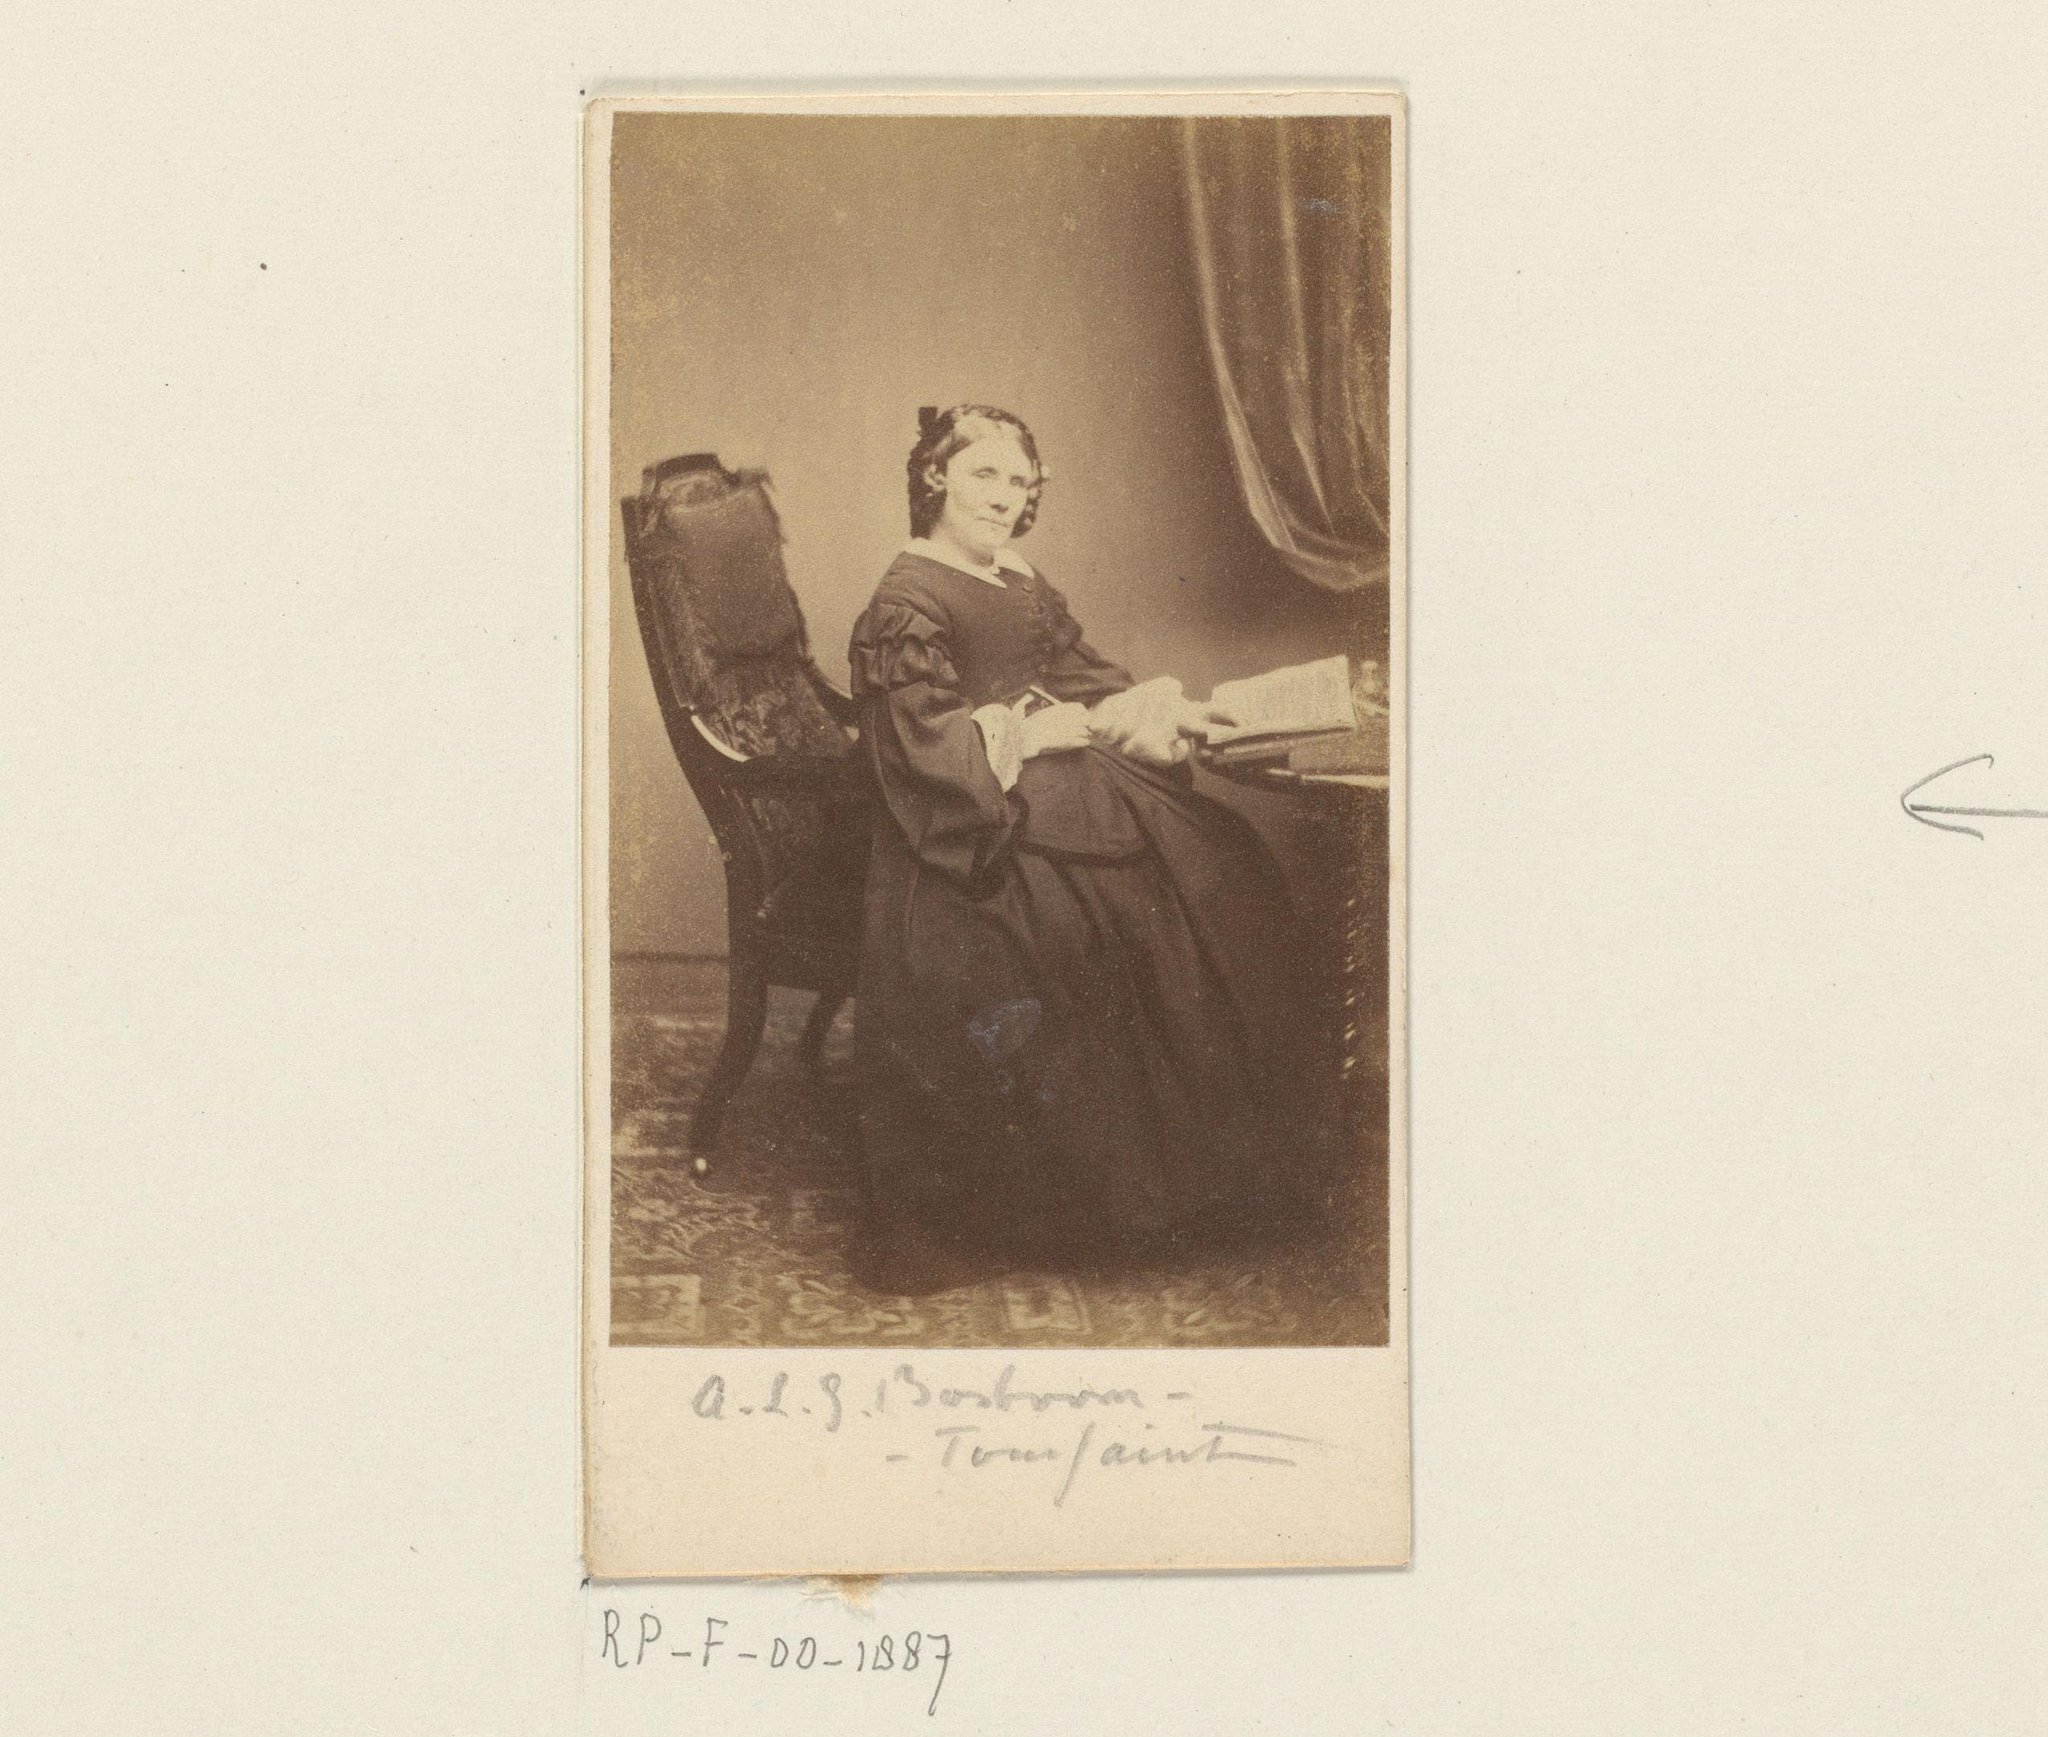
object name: carte de visite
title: Portret van A.L.G. Bosboom-Toussaint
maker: maurits verveer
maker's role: painter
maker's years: 1817-1903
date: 1860-1870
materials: cardboard, paper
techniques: albumen print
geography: the hague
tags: the hague, anna louisa geertruyda bosboom-toussaint, historical persons, writer, poet, author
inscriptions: inscription: ‘A.L.G. Bosboom-/ Toussaint’, inscription: ‘[...] vis à vis’, inscription: ‘M. Verveer,/ Photographe./ La Haye’